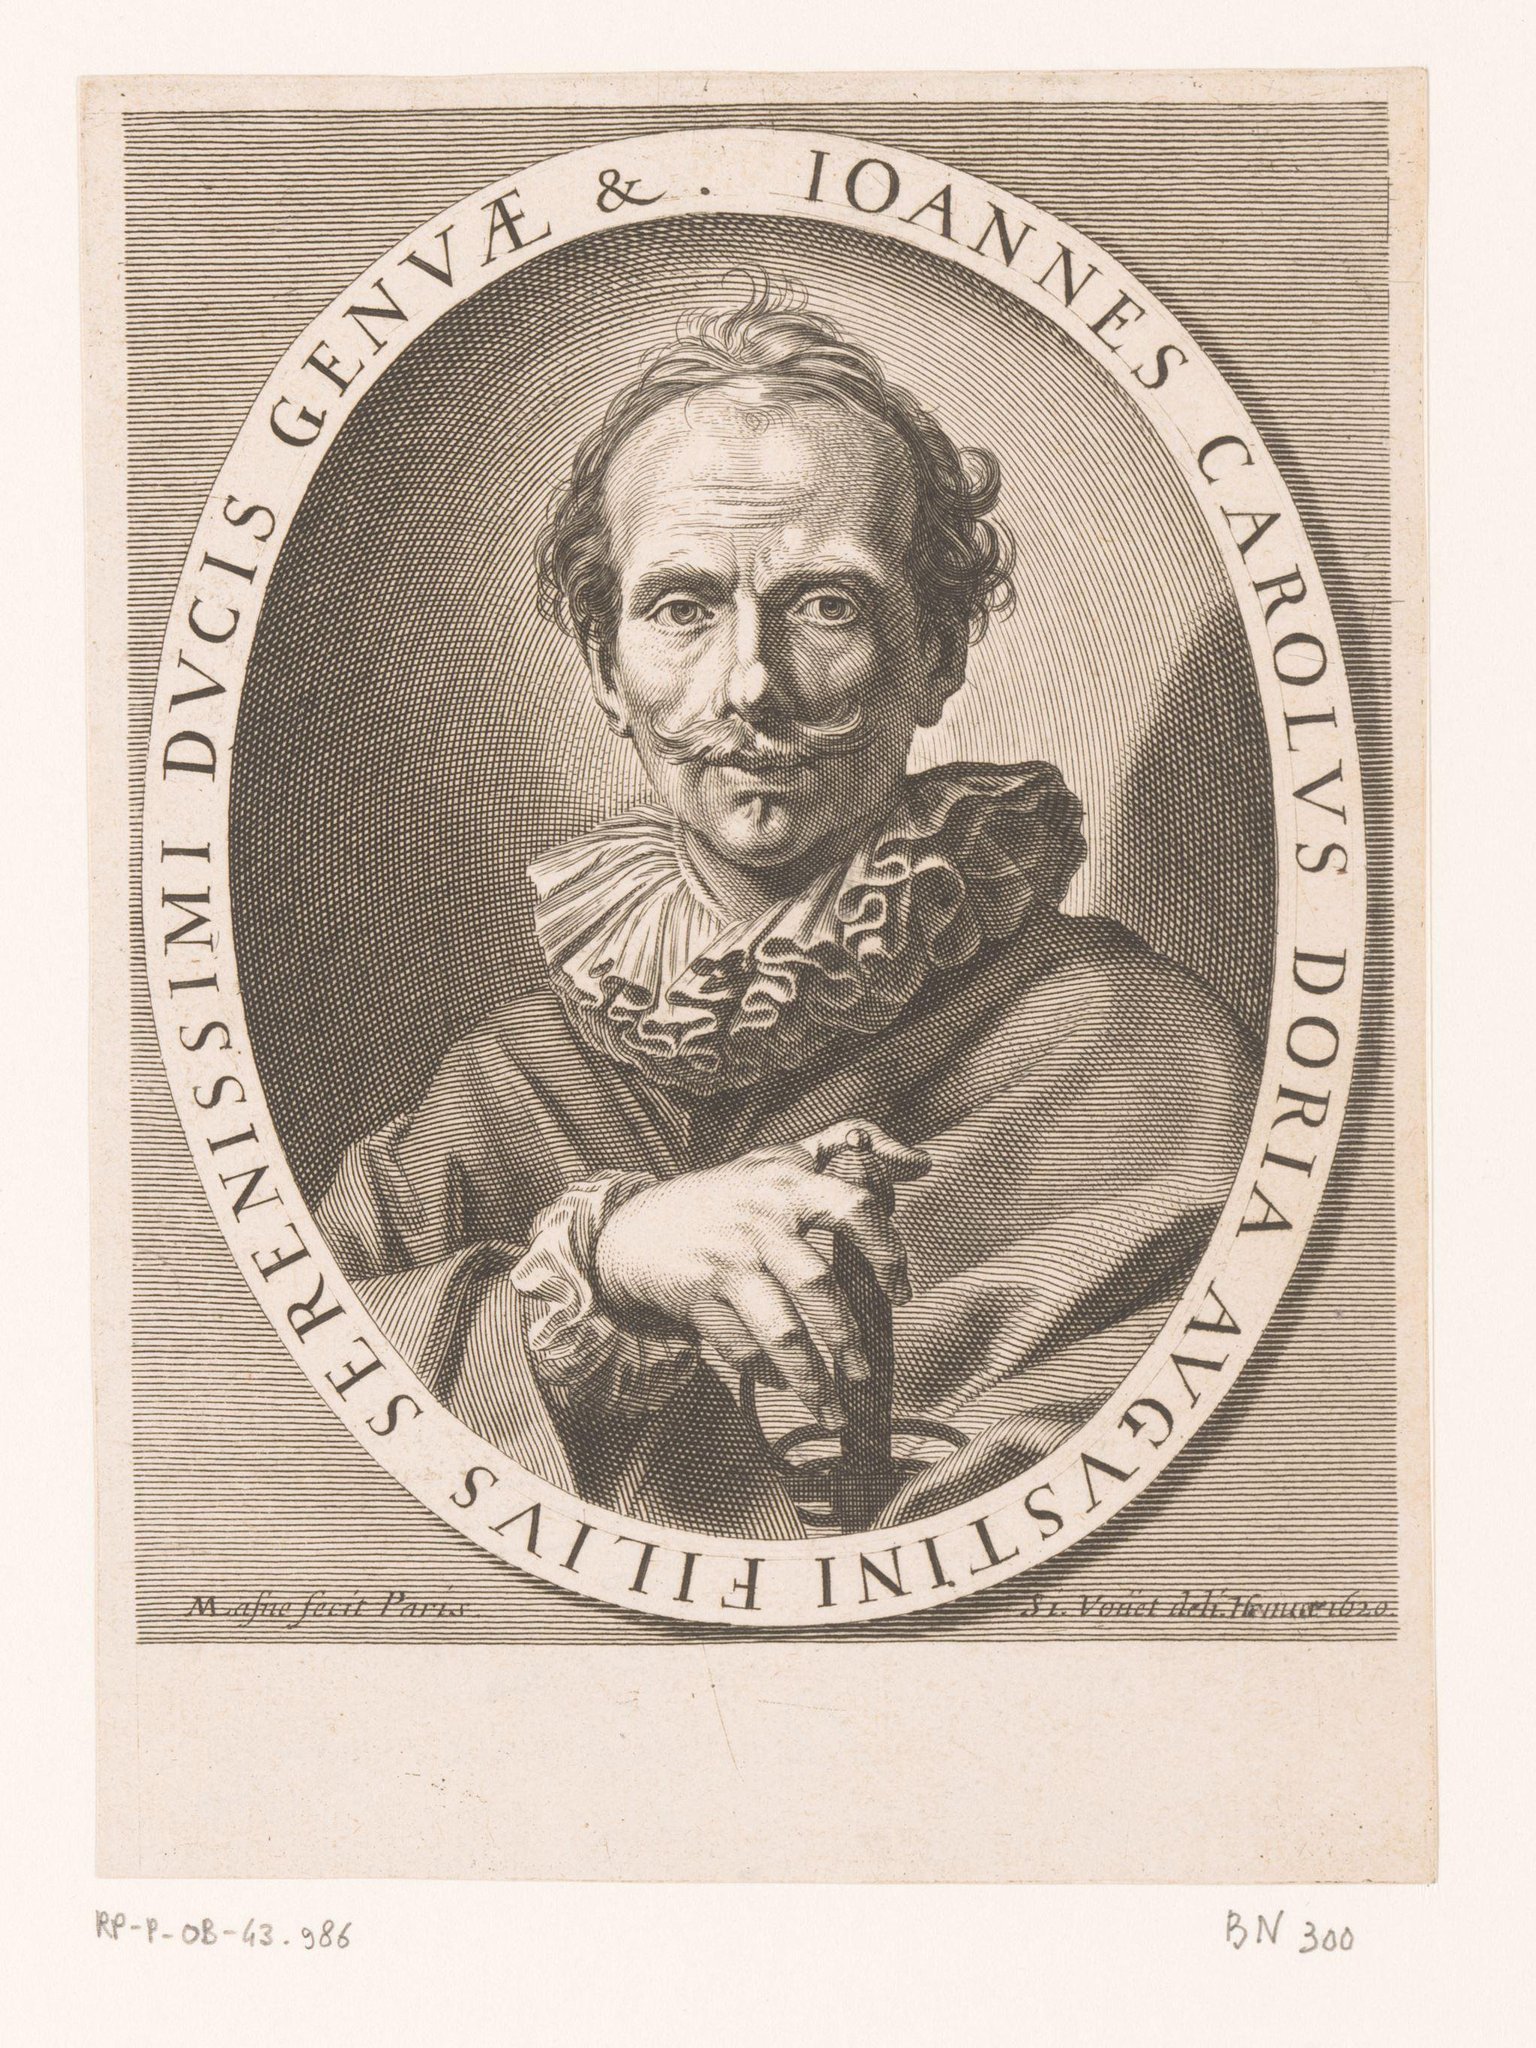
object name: print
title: Portret van Giovanni Carlo Doria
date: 1620-1667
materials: paper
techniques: engraving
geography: paris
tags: historical persons, art collector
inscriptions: collector's mark: Lugt 2228